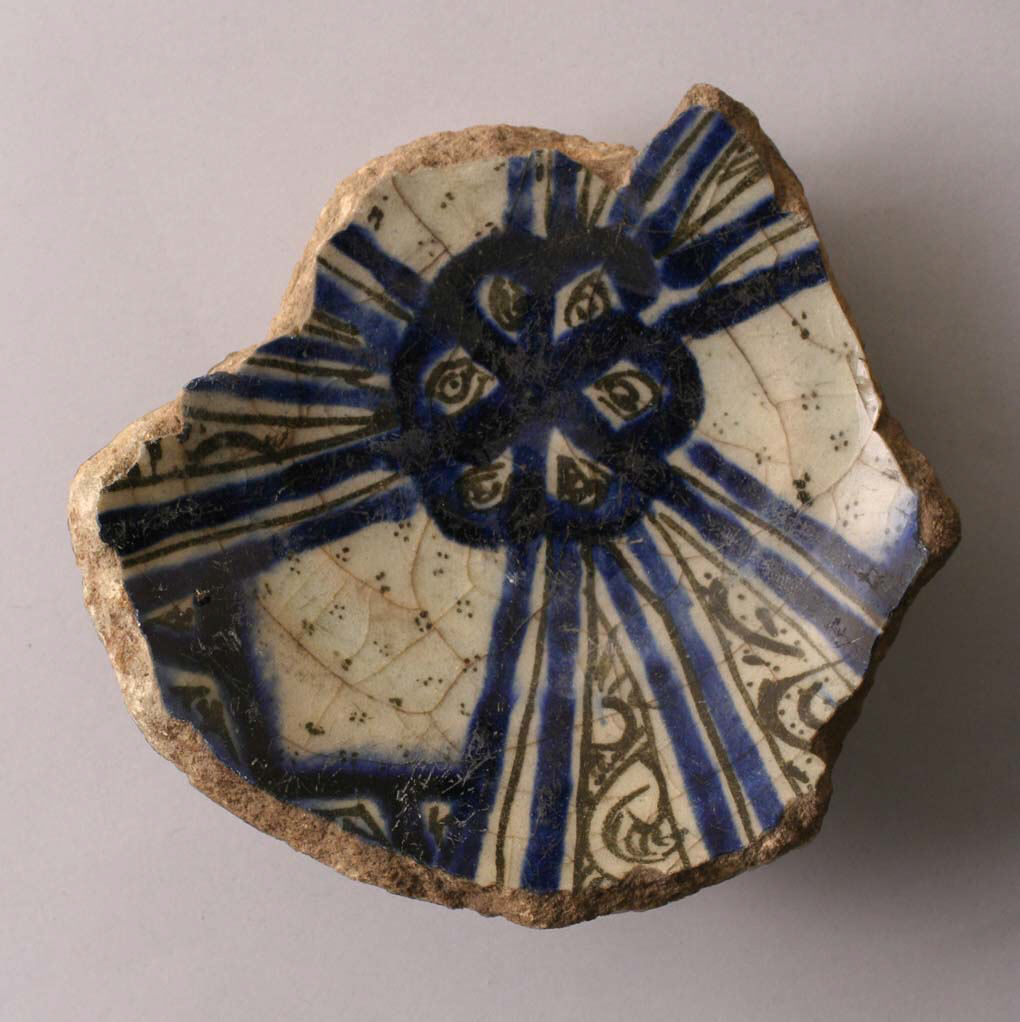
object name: fragment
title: Fragment of a Dish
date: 1301-1500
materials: glaze, stonepaste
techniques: painting, polychrome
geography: egypt